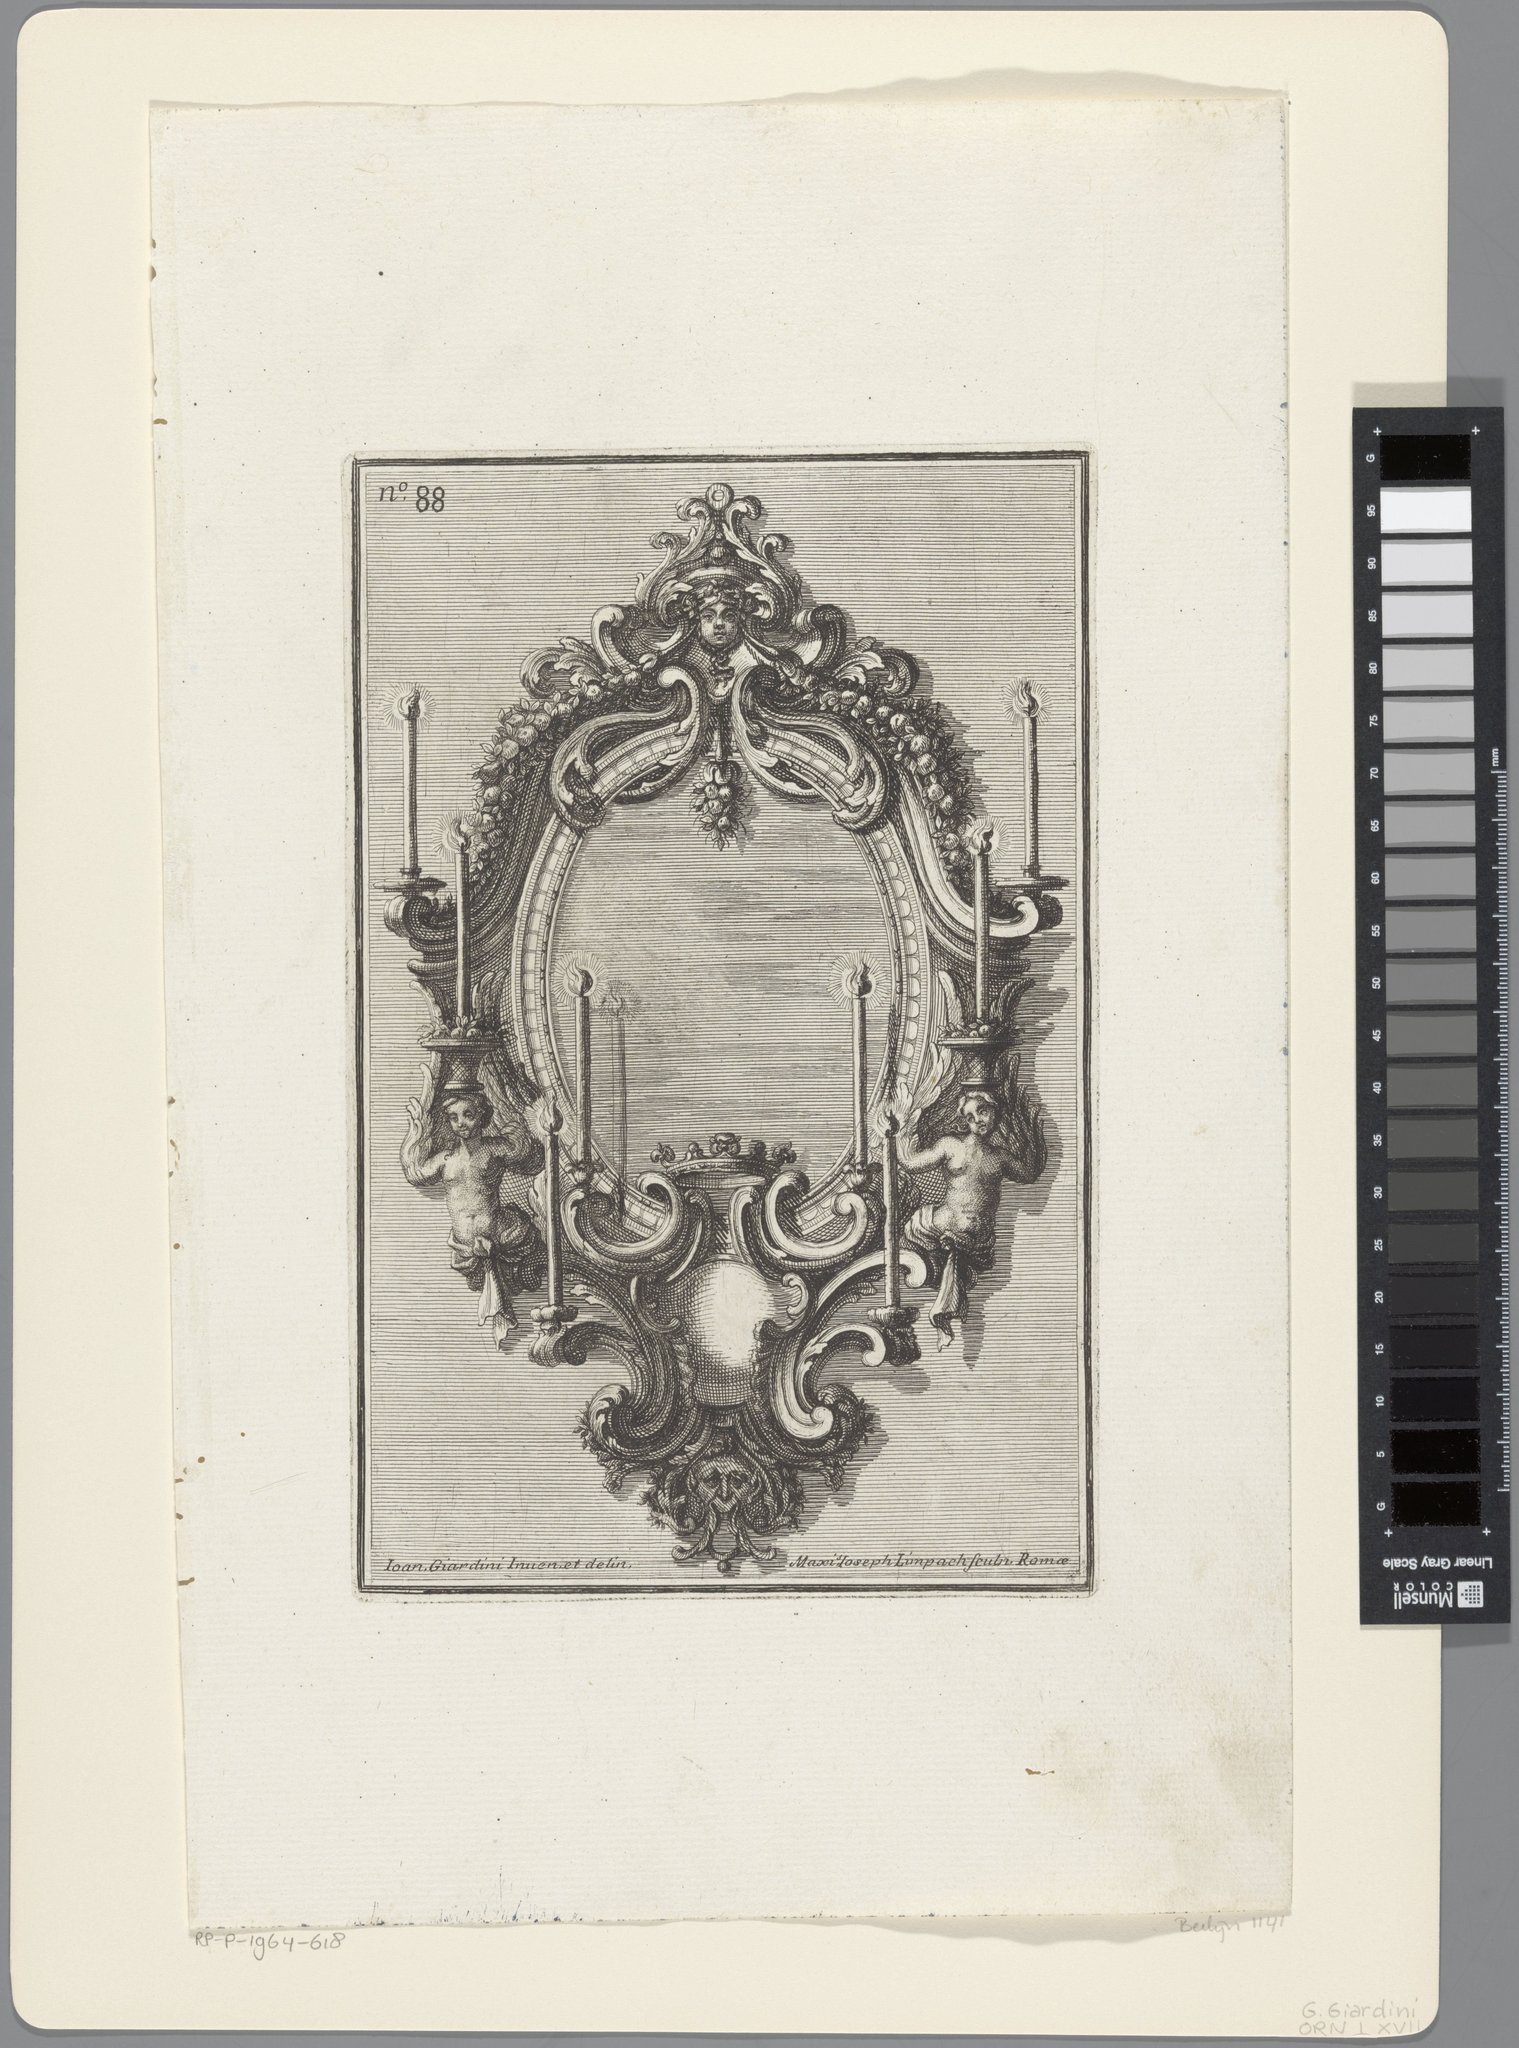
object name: ornament print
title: Wandkandelaar met twee gevleugelde figuren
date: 1714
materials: paper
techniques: etching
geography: vatican city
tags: fabulous beings with wings - aa - female human figure, chandelier, candelabrum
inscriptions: collector's mark: Lugt 2228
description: Prent maakt deel uit van een reeks van 100 ornamentprenten naar ontwerp van Giovanni Giardini.